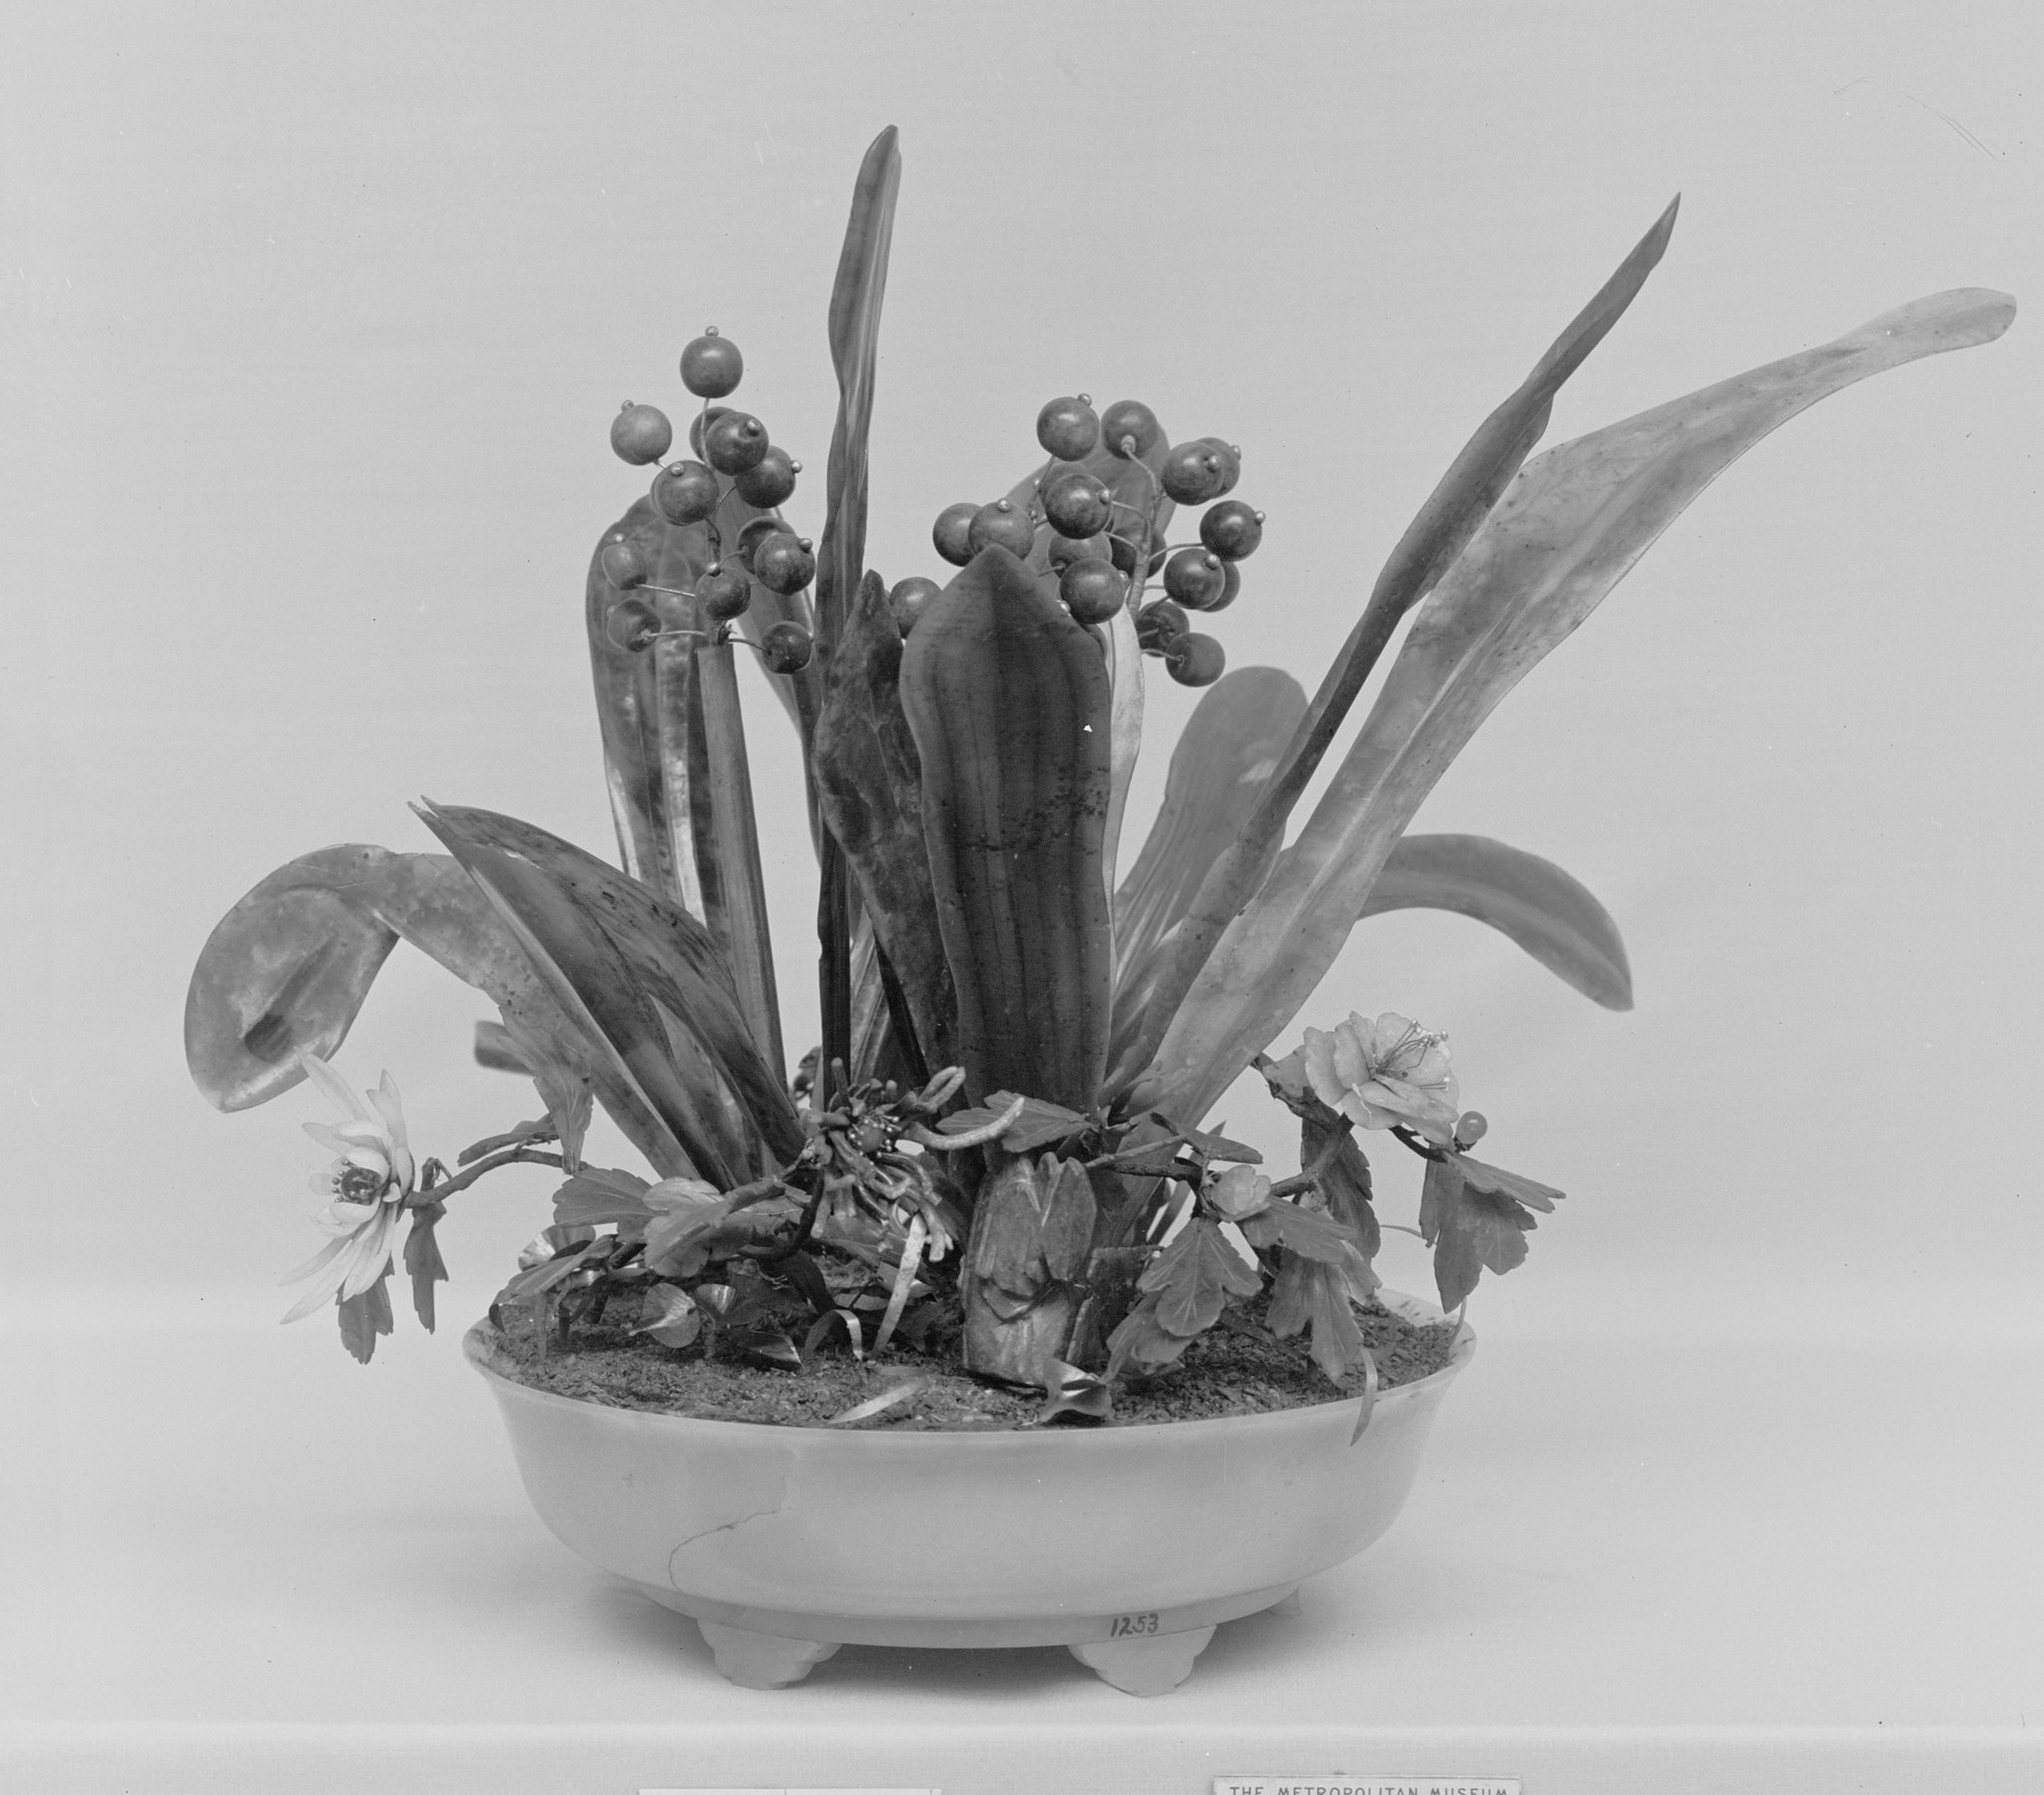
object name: dish of artificial plant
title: Dish of Artificial Plants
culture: chinese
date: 1736-1795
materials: coral, jade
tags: plants